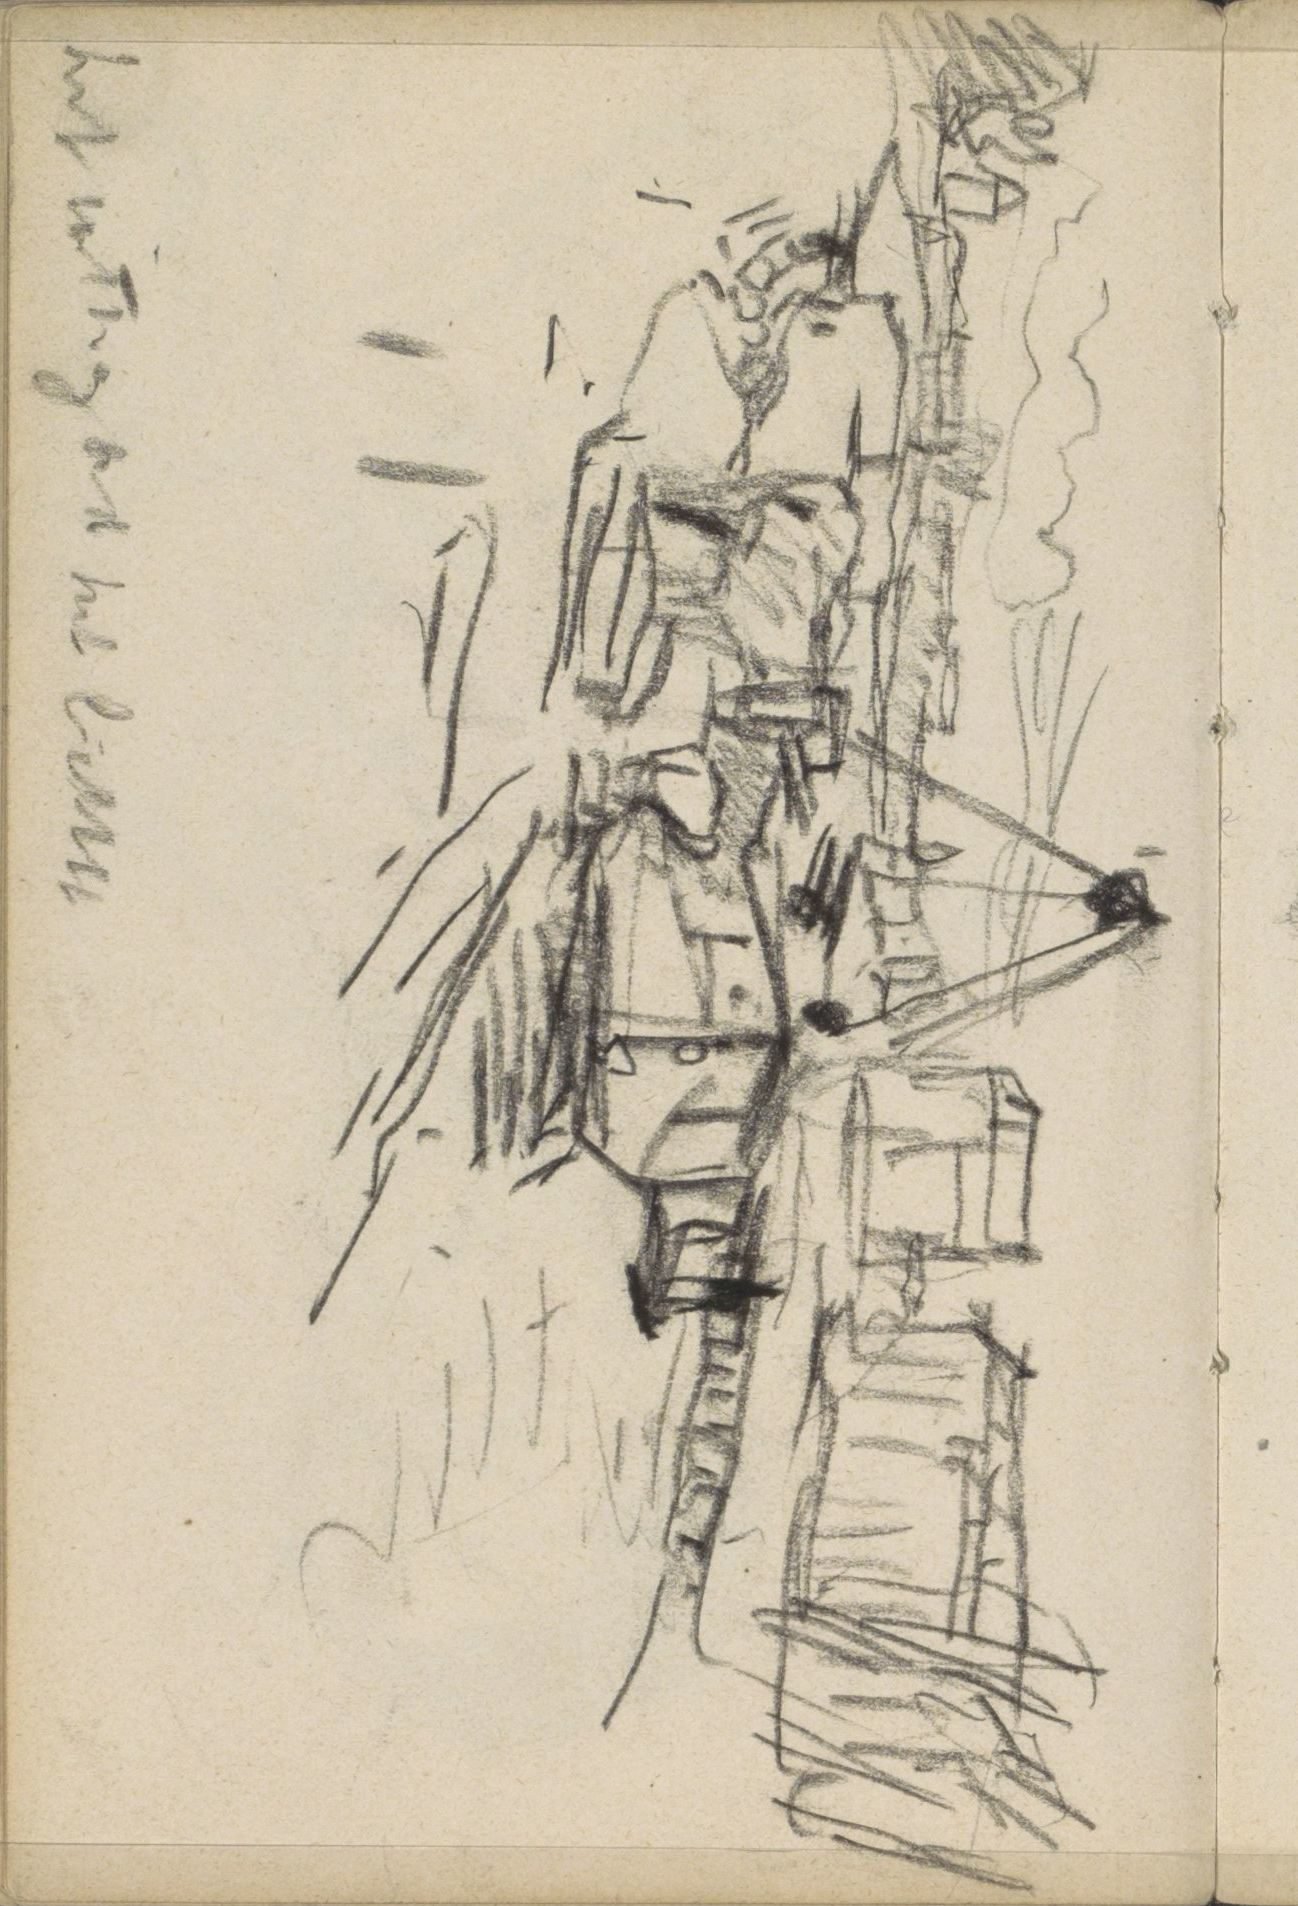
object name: sketchbook leaf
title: Stadsgezicht met water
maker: george hendrik breitner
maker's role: draughtsman, painter, print maker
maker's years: 1857-1923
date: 1903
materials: chalk, paper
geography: amsterdam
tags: building activities, urban housing, ships (in general)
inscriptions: kleurnotitie, handgeschreven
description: Stadsgezicht, mogelijk Amsterdam, met water. In het water een boot. Pagina 55 uit een schetsboek met 46 bladen.